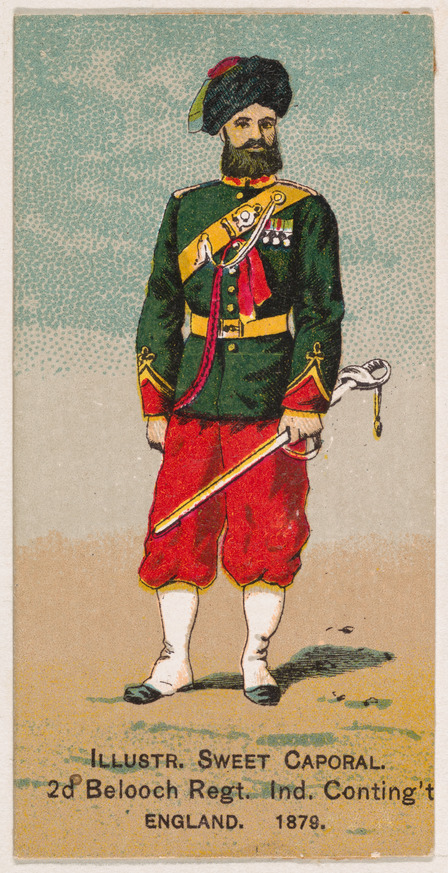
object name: print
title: 2nd Belooch Regiment, Ind. Conting't, England, 1879, from the Military Series (N224) issued by Kinney Tobacco Company to promote Sweet Caporal Cigarettes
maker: kinney brothers tobacco company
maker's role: publisher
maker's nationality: american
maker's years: 1869-2011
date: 1888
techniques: color lithograph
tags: military,men